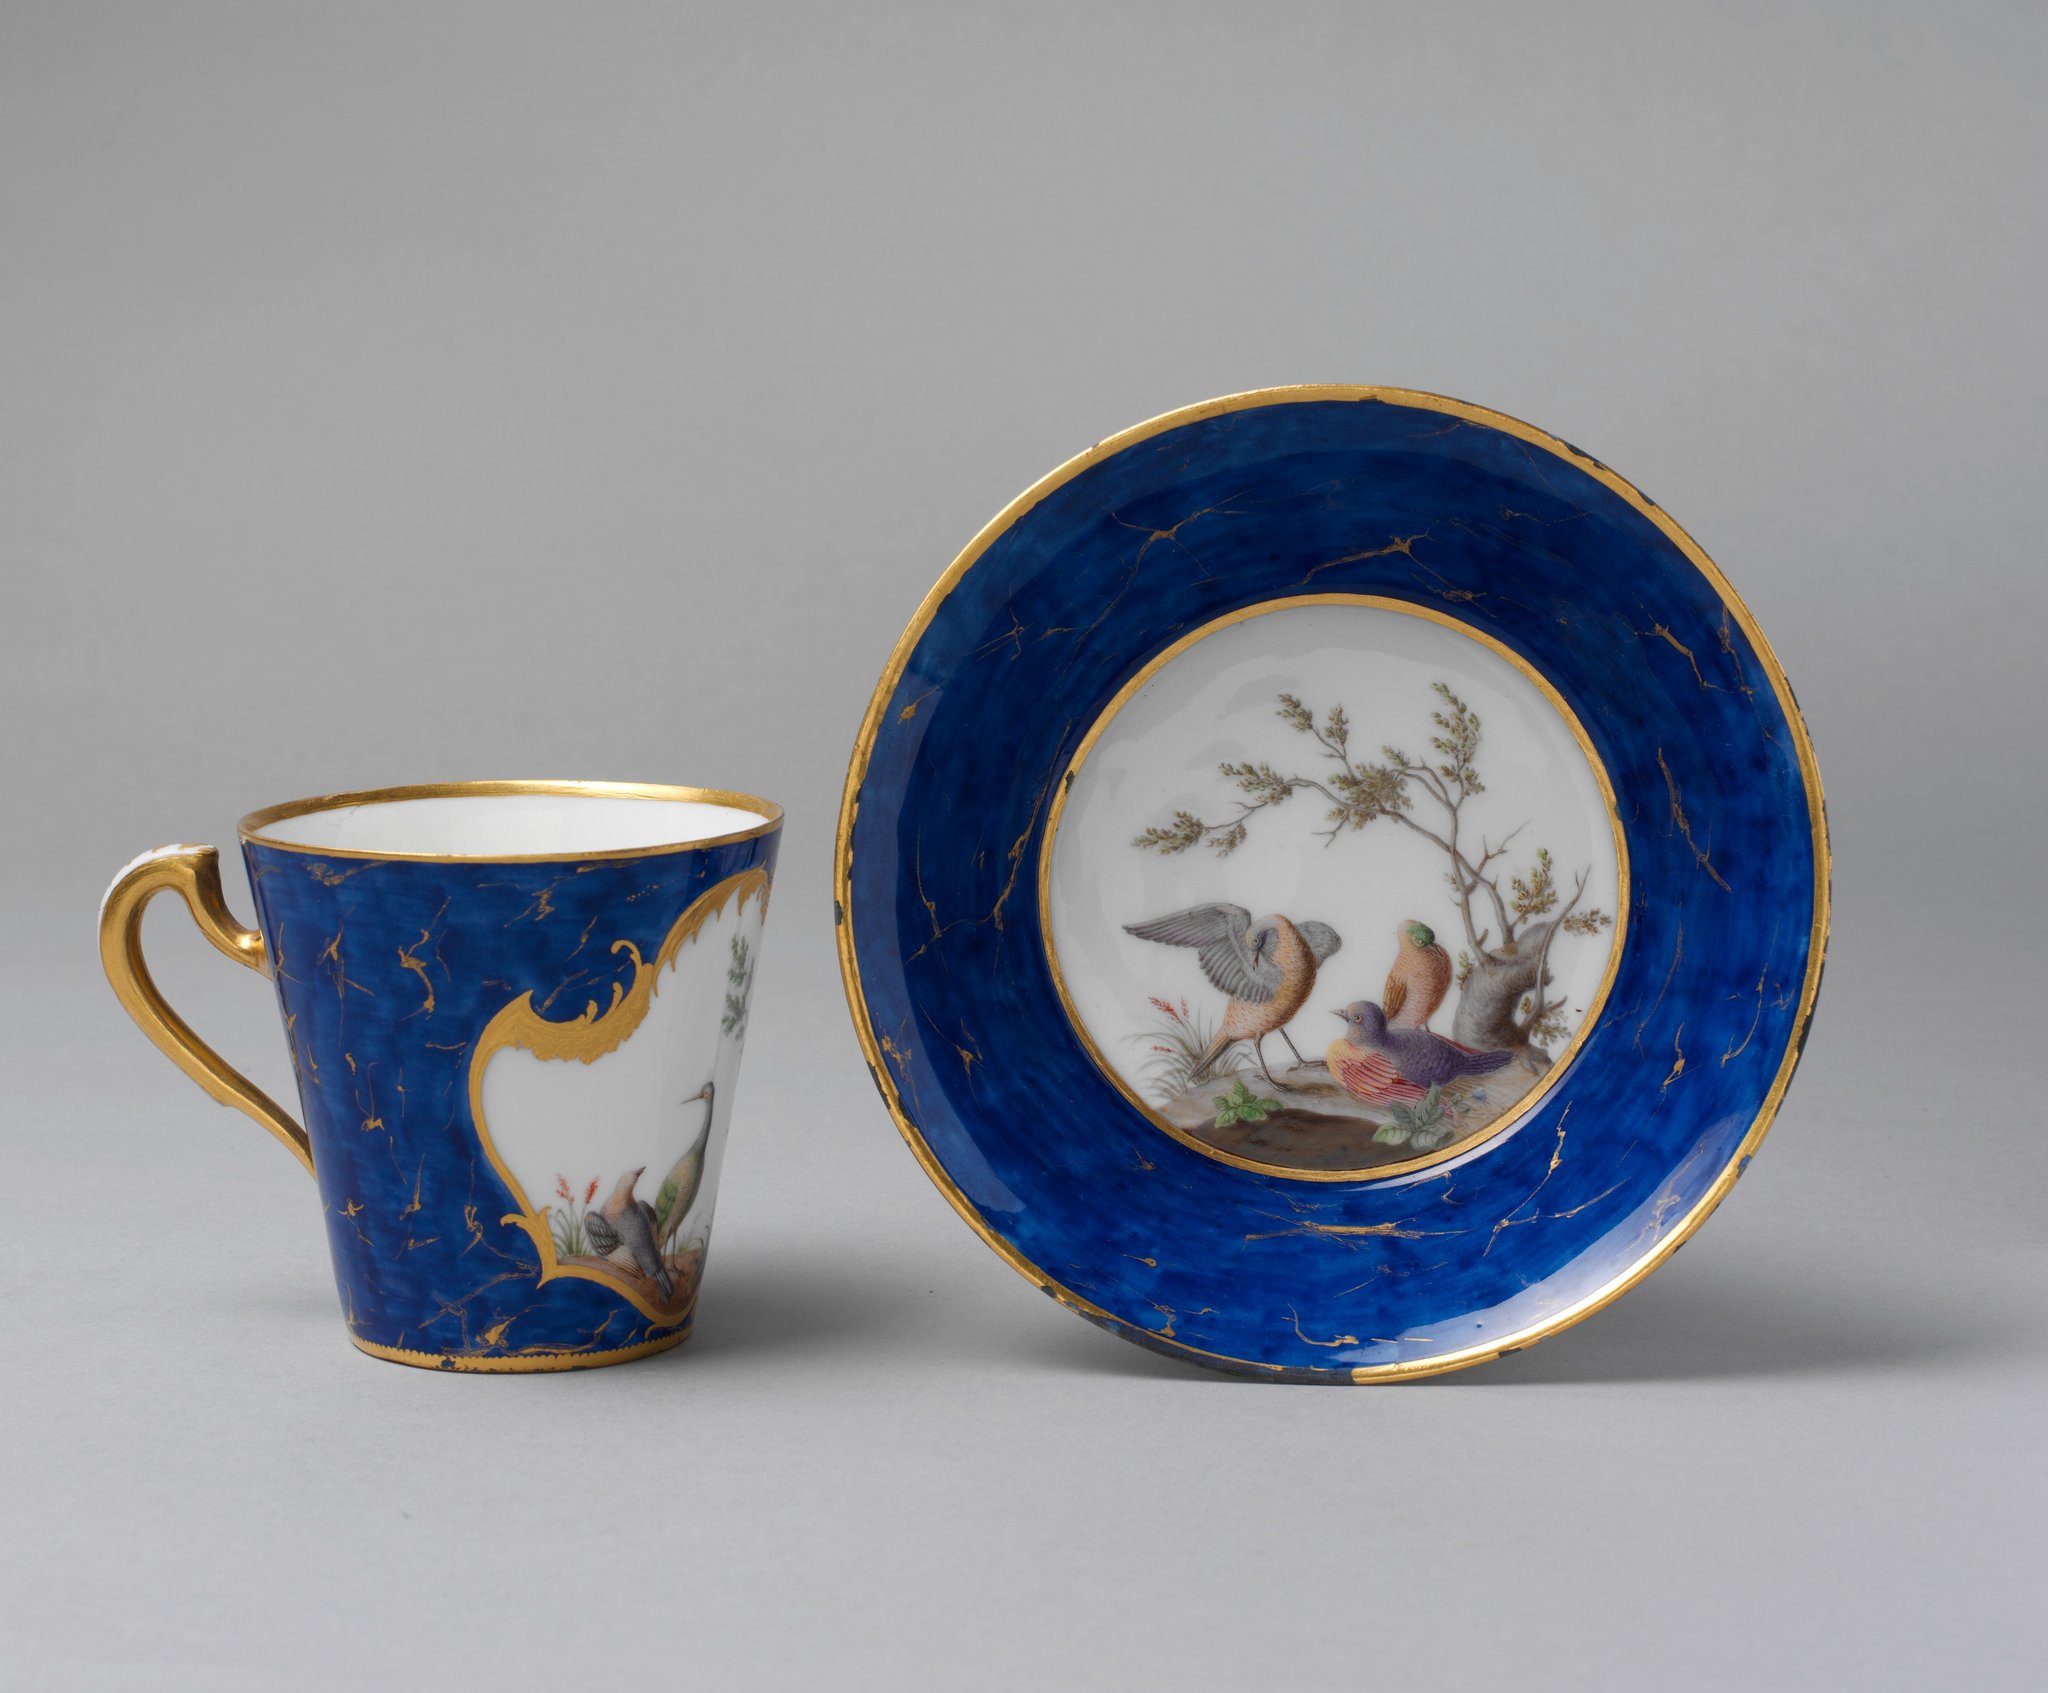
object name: cup and saucer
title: Cup and saucer (gobelet à lait et soucoupe)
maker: vincennes manufactory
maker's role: manufactory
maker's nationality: french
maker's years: 1740-1756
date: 1752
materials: soft paste porcelain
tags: birds,plants